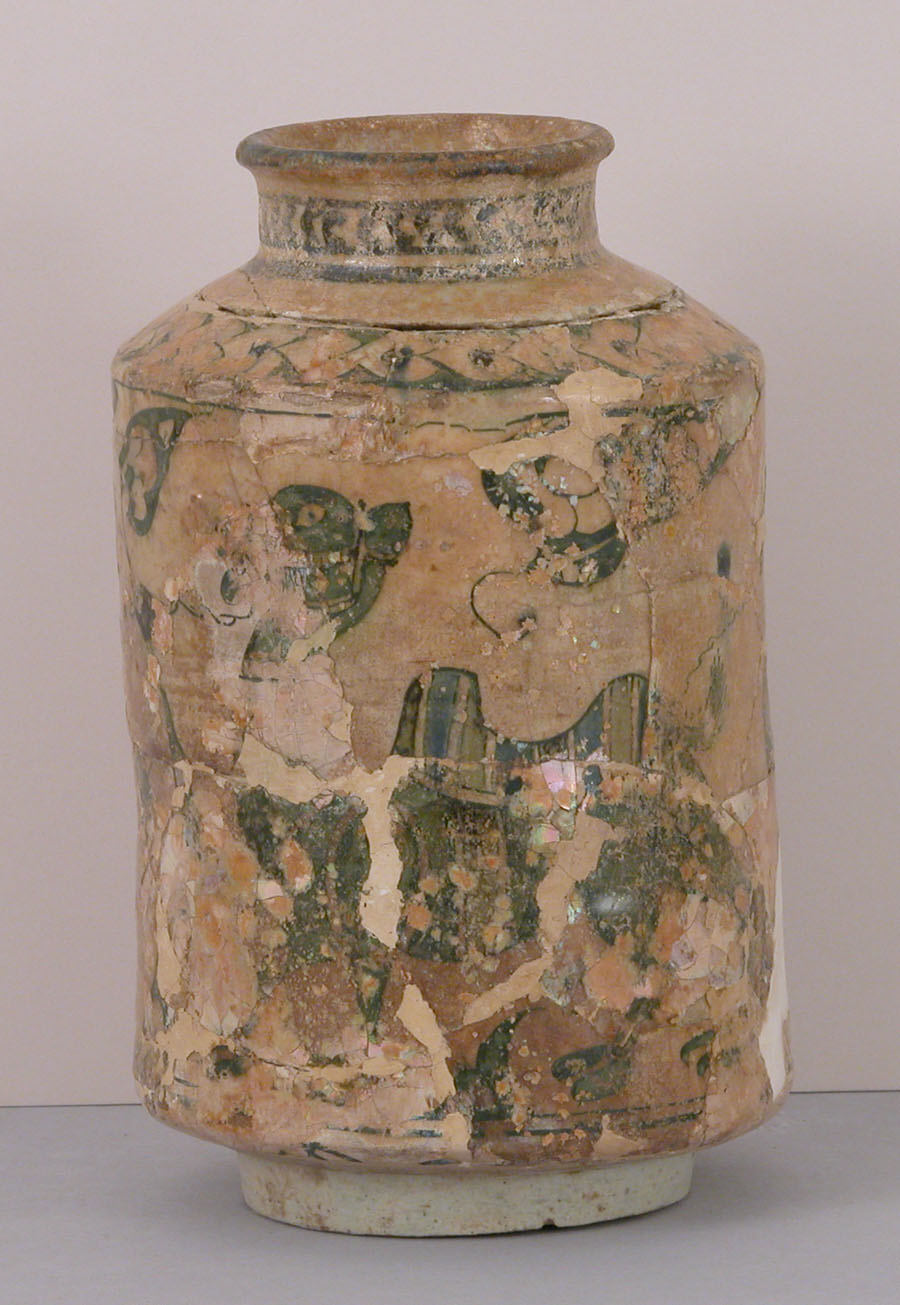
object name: jar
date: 1101-1300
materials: stonepaste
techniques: painting, underglaze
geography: syria